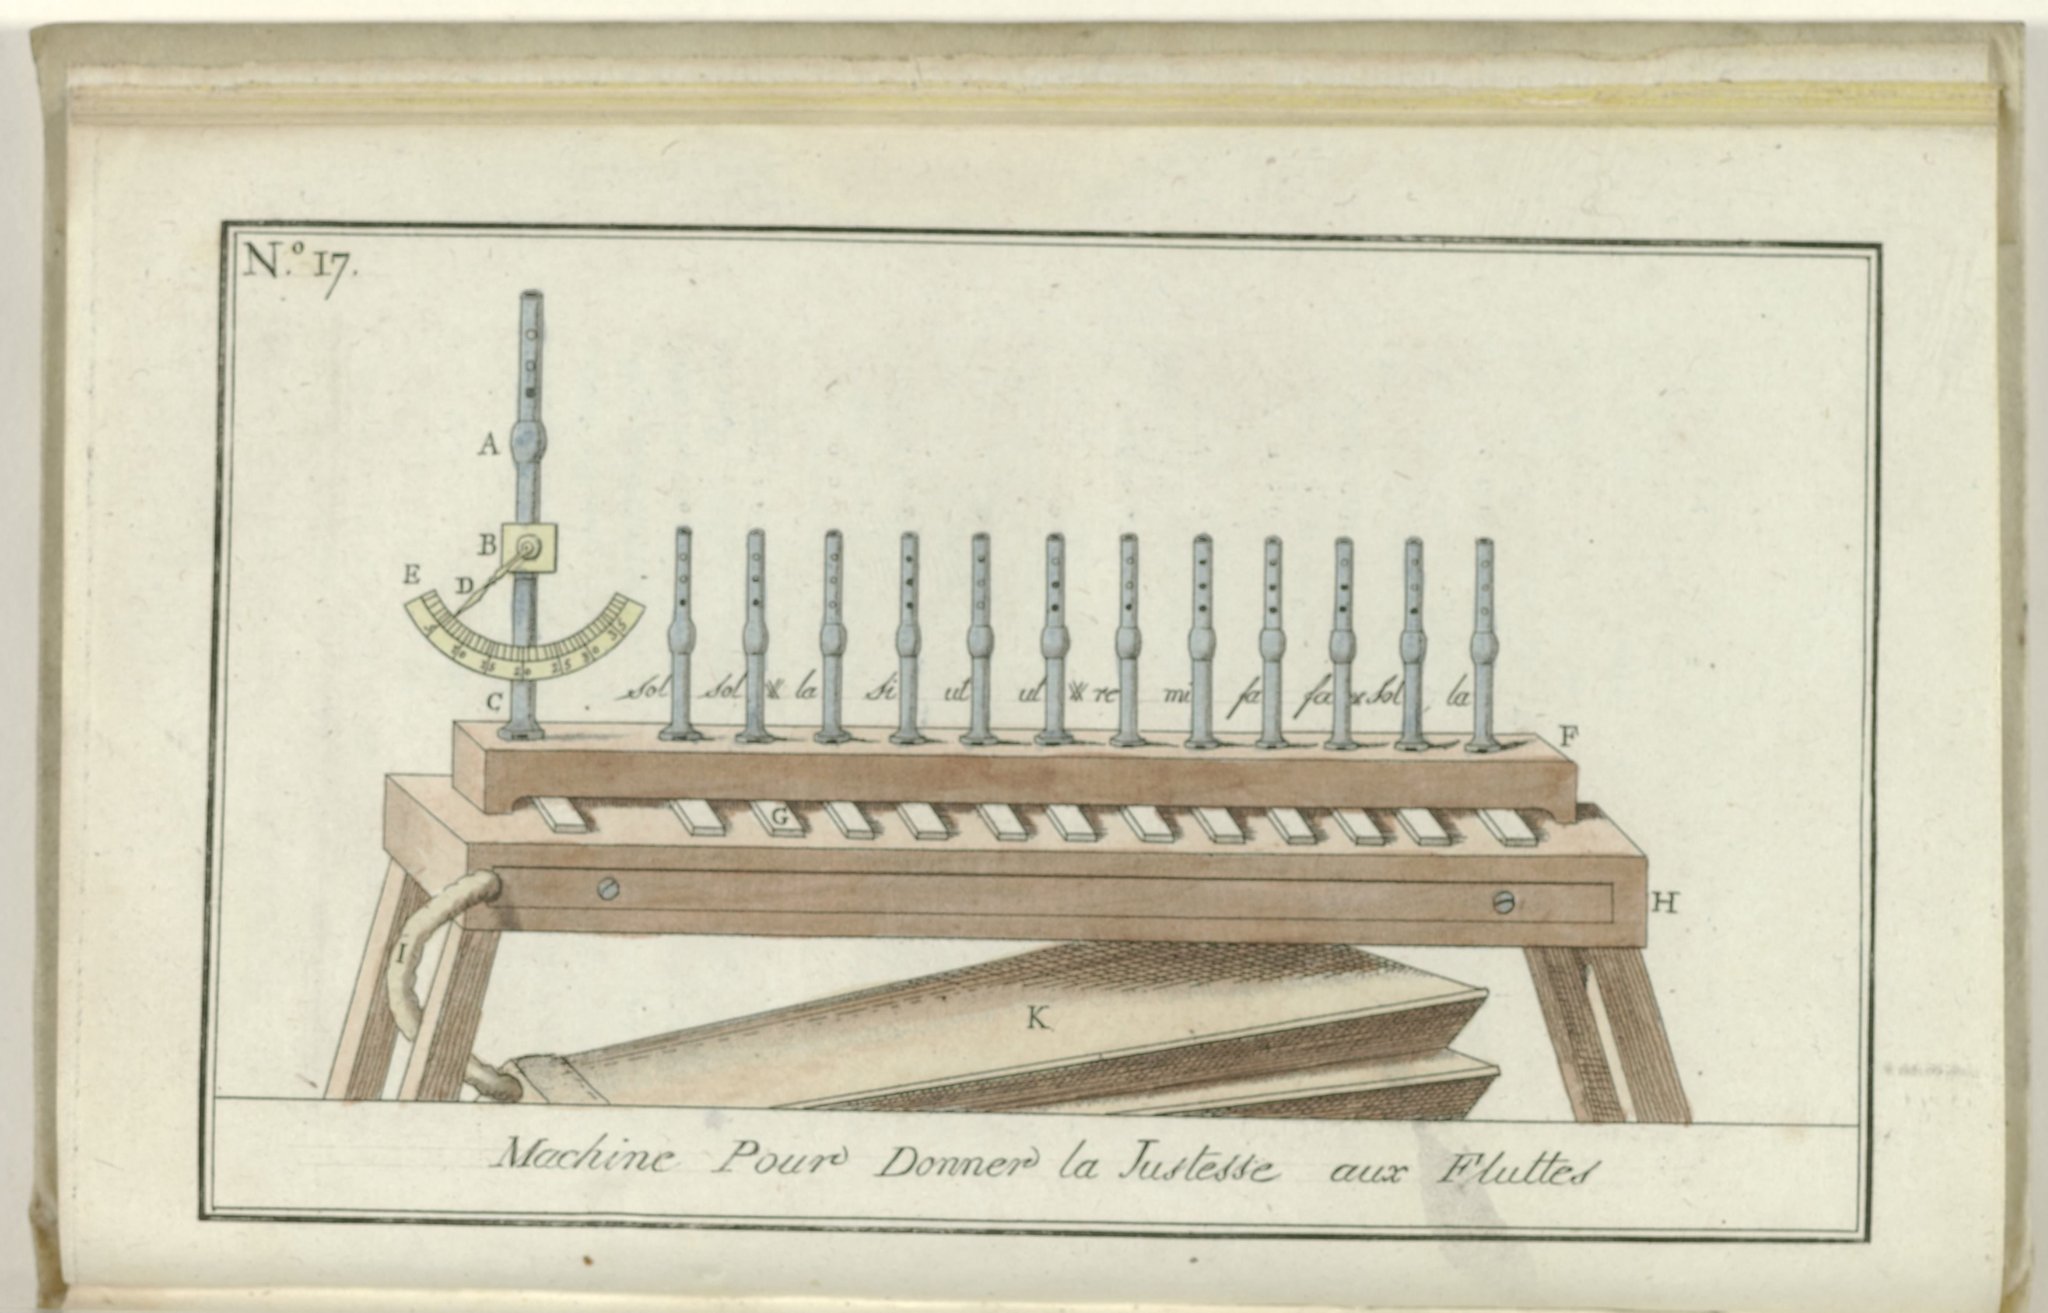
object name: print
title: Le Mois, Journal historique, littéraire et critique, avec figures, no. 17: Machine pour donner la Justesse aux Fluttes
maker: Anonymous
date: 1800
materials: paper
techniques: etching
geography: théâtre des folies-marigny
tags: recorder (musical instrument)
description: Werkbank waarop 13 blokfluiten. Prent uit het tijdschrift Le mois : journal historique, littéraire et critique avec figures, 1800.